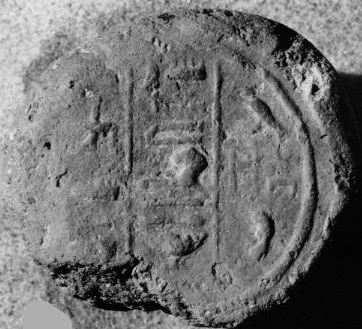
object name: cone, circular impression, amenemhat, goldsmith, amun re, tahut, house mistress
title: Funerary Cone of Amenemhat and His Wife Tahut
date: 1550-1295 BCE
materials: pottery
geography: egypt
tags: hieroglyphs